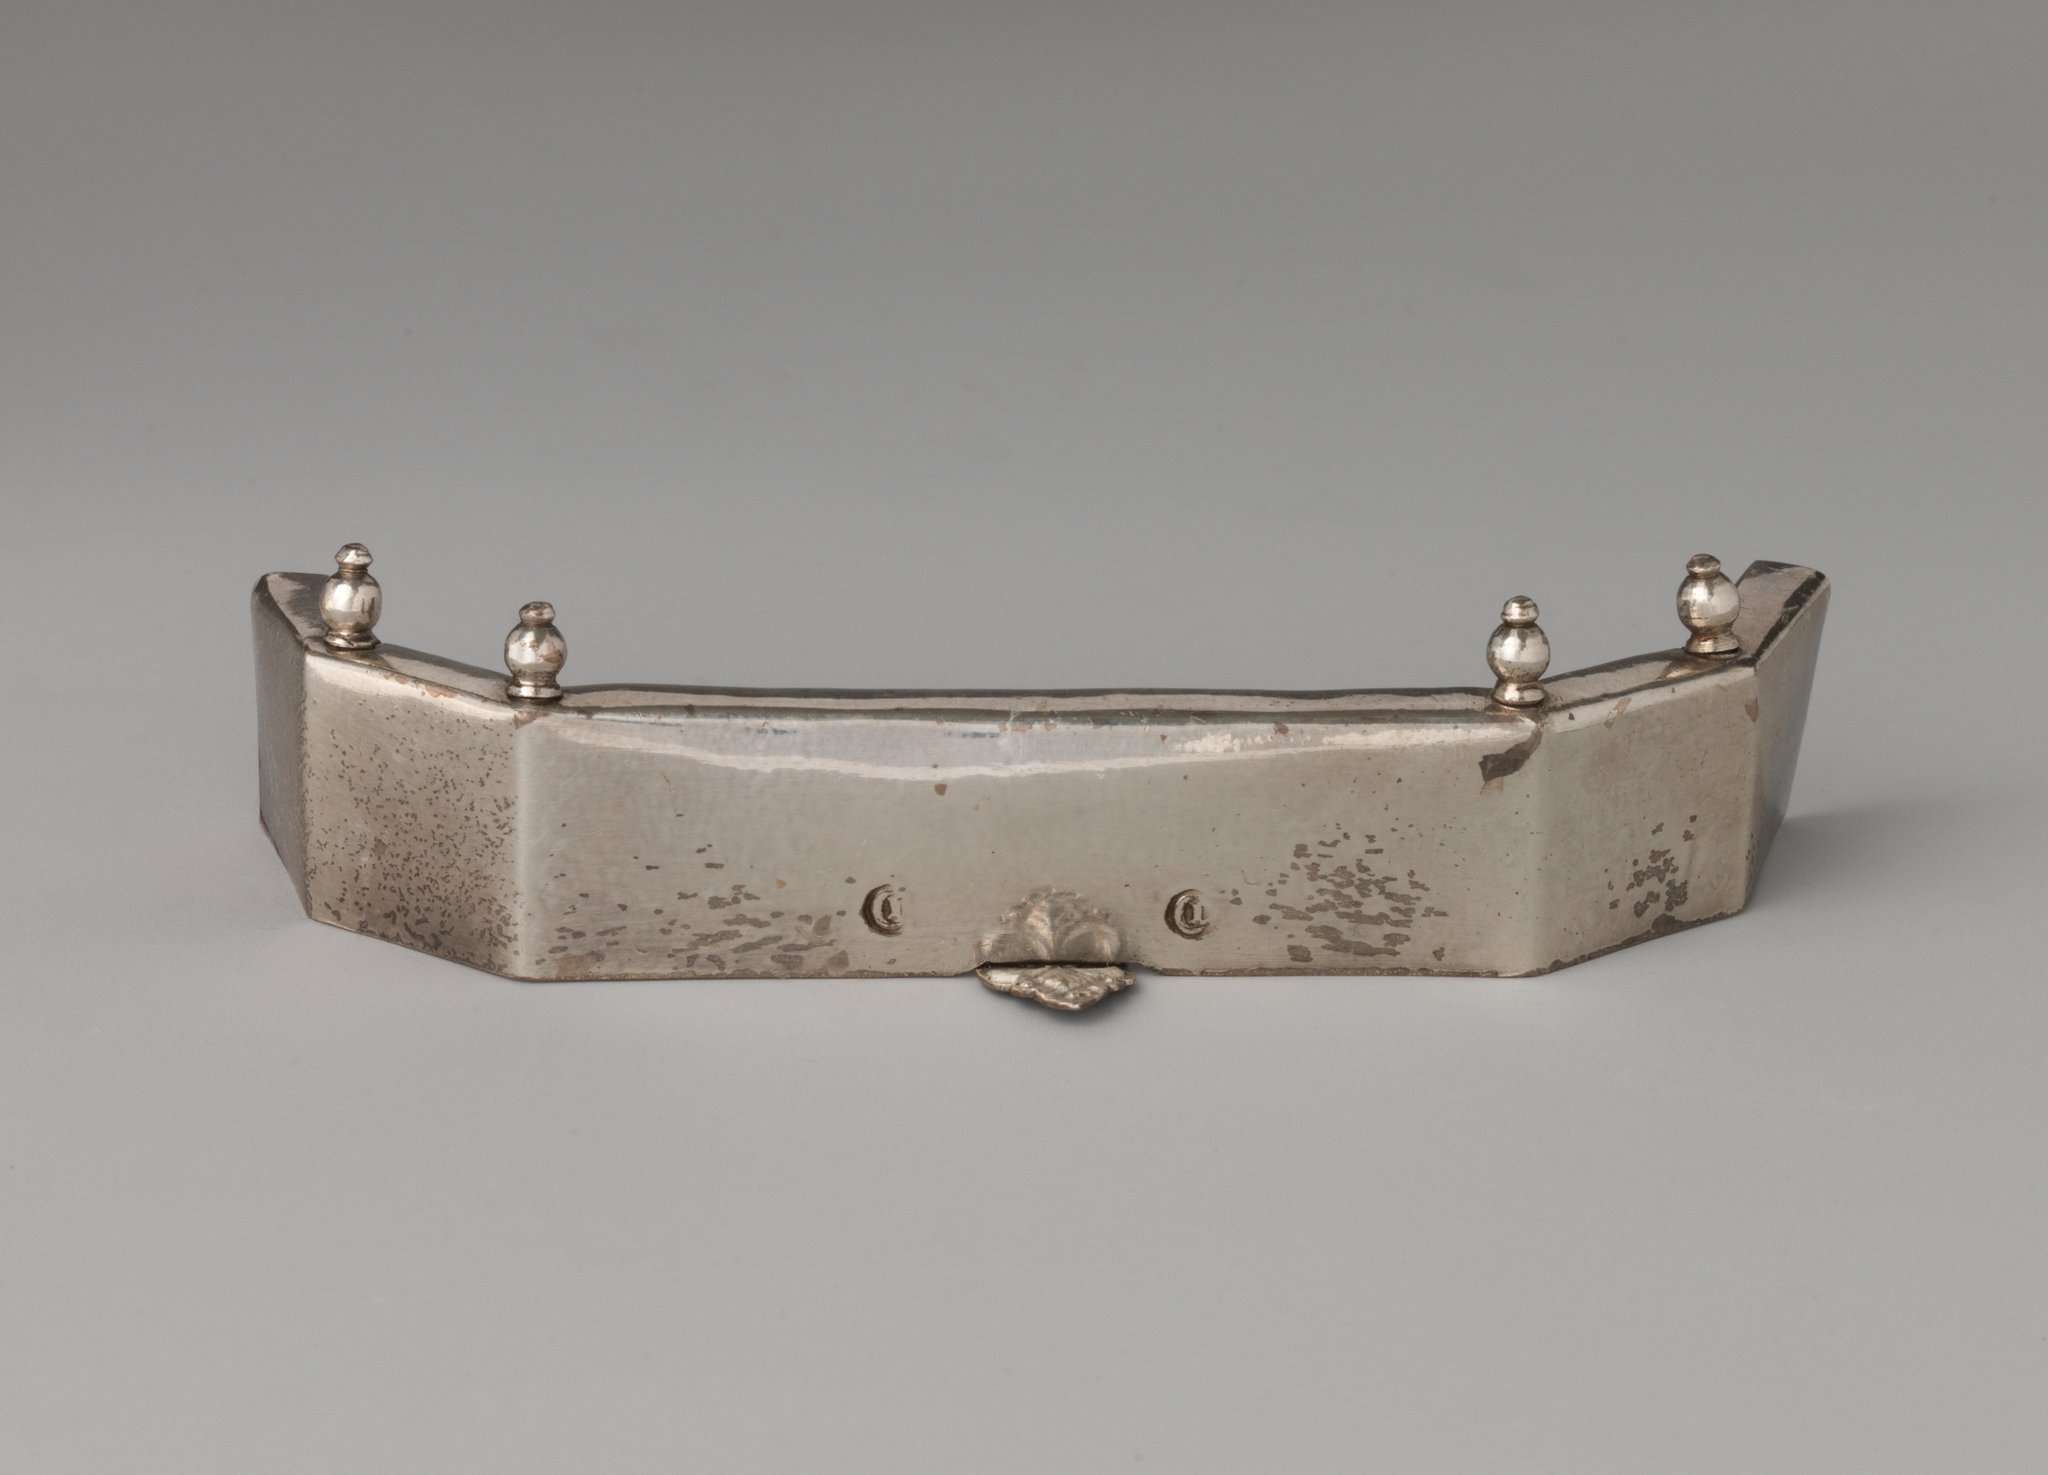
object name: fender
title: Miniature fender (part of a set)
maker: david clayton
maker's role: maker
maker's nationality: british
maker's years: 1659-1719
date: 1667-1733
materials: silver